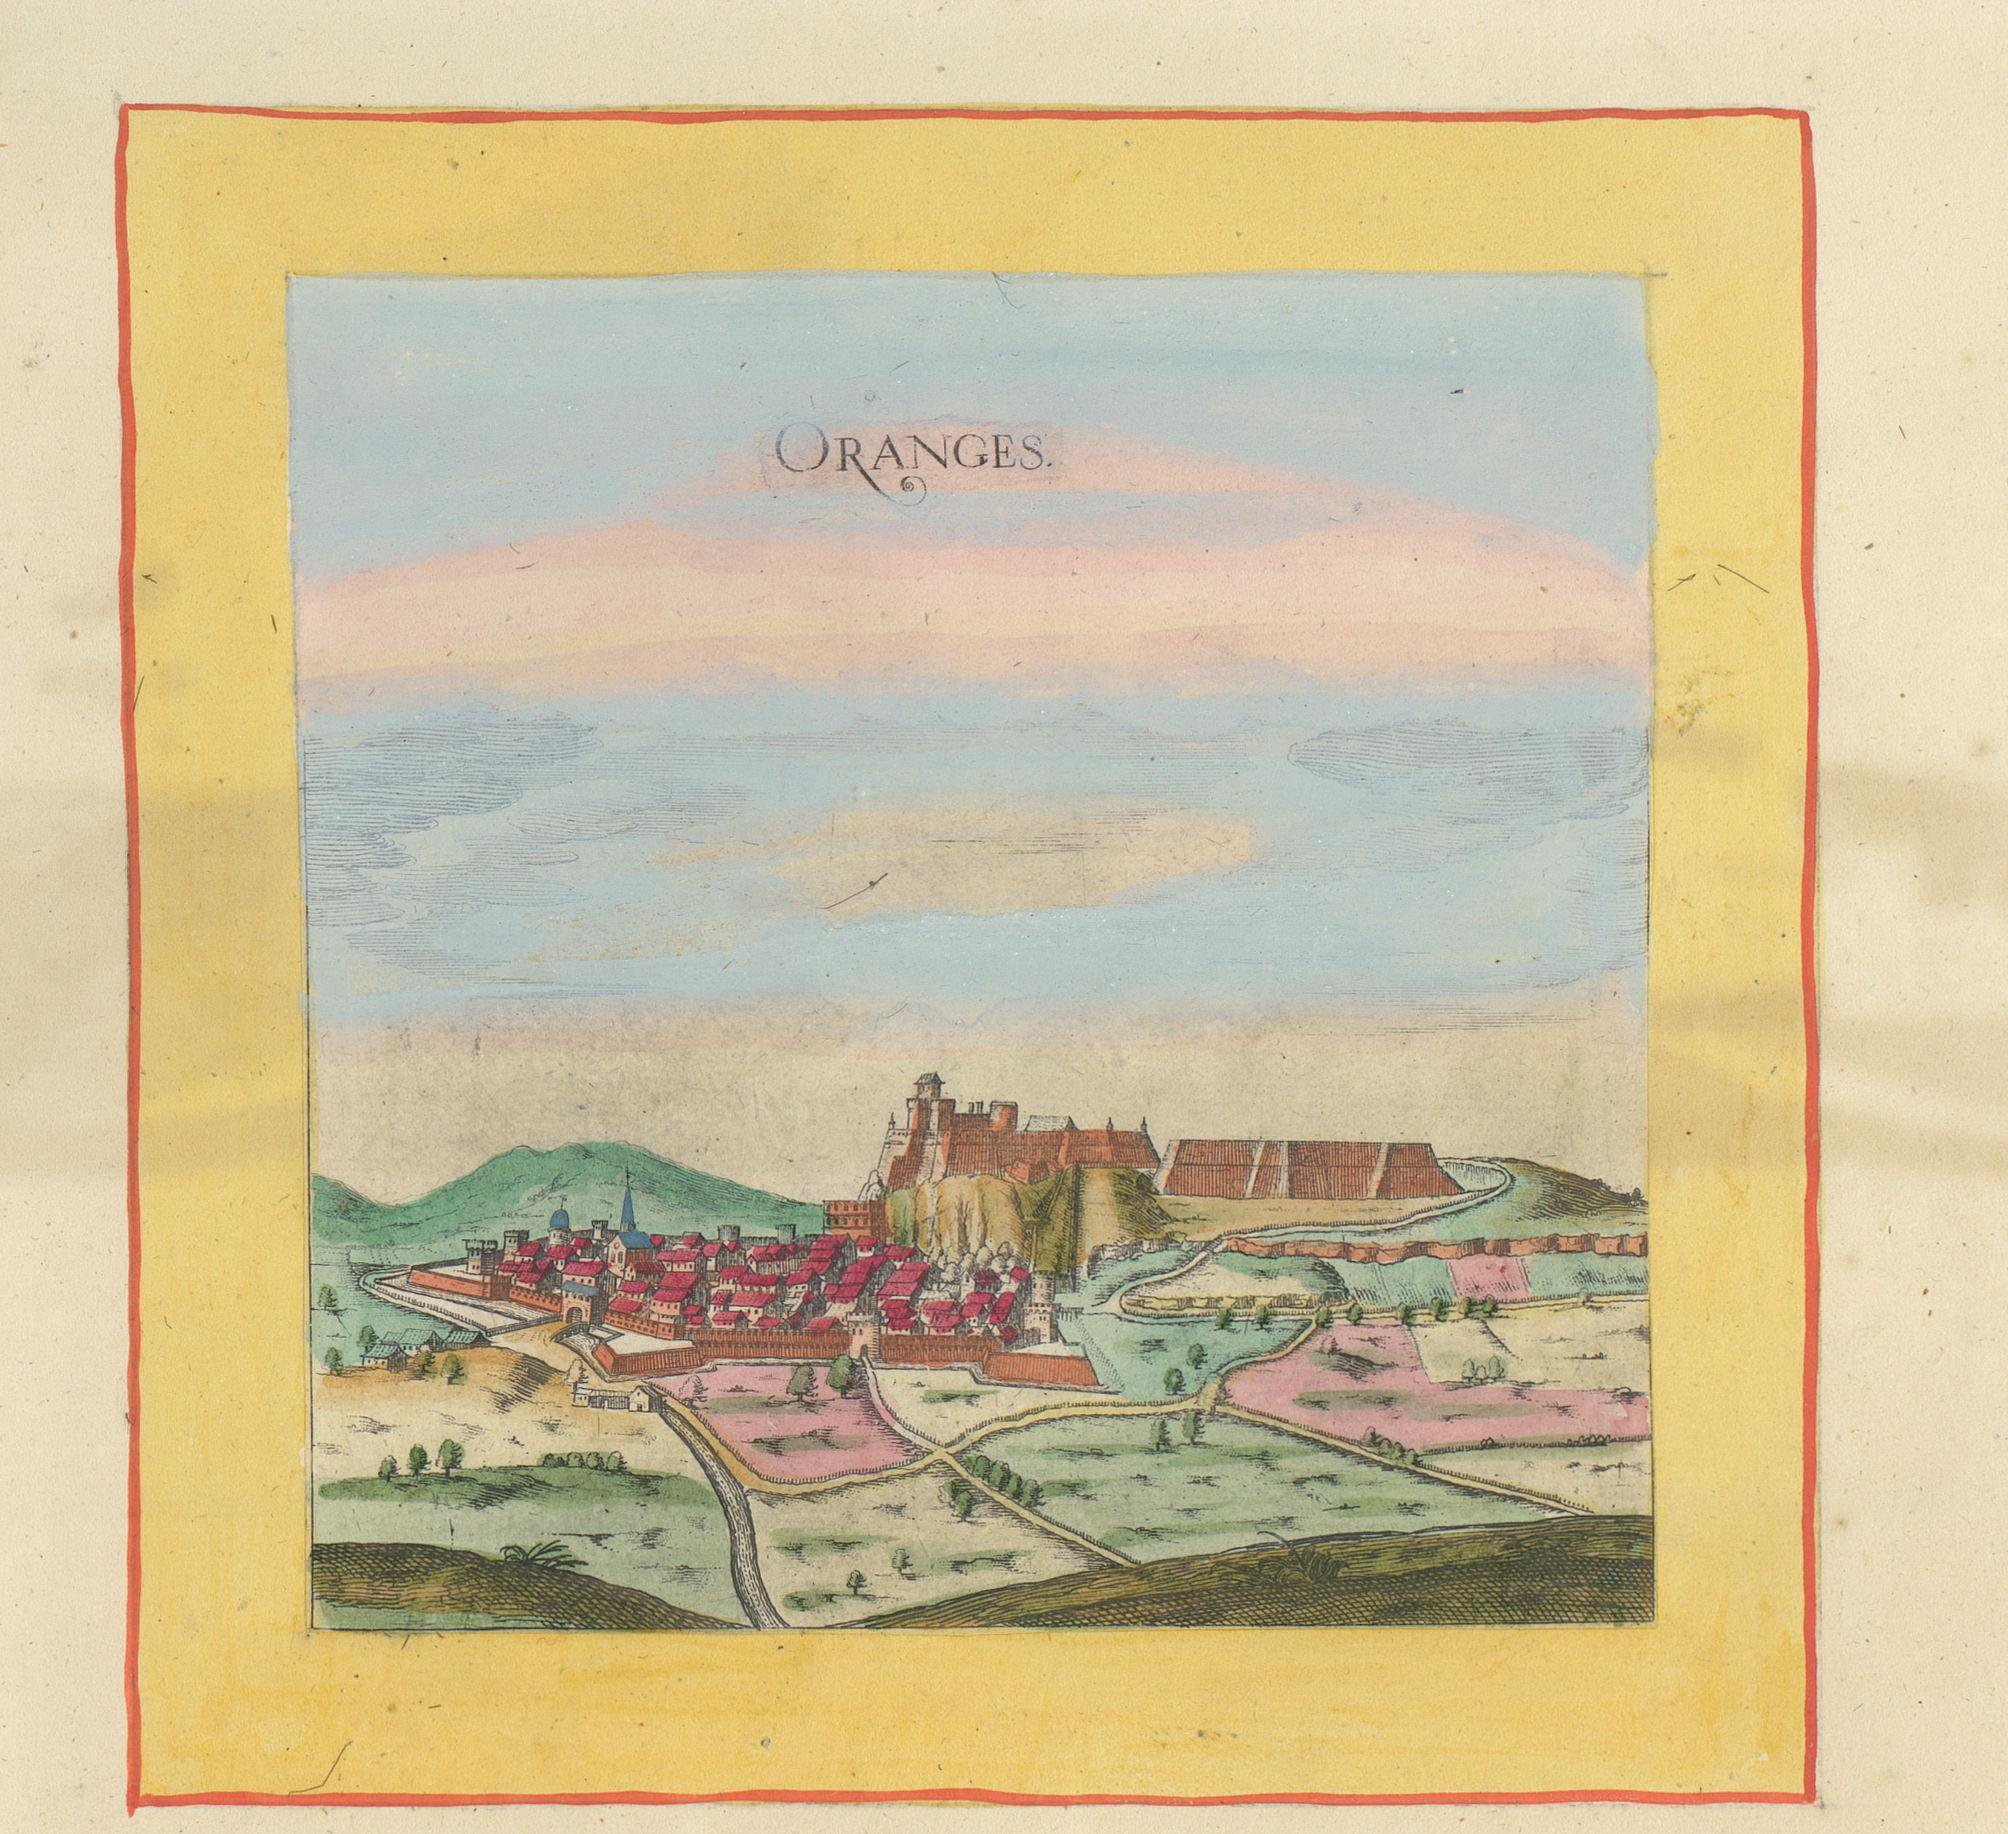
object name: print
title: Gezicht op Orange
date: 1638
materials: paper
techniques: engraving, etching, hand coloring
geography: the hague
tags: city-view in general; 'veduta'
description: Prent uit: Tassin, Christophe. Les plans et profils de toutes les principales villes et lieux considérables de France (...). Parijs: Michel van Lochom, 1638, prent 3 uit het deel 'Principaute d'Oranges'.